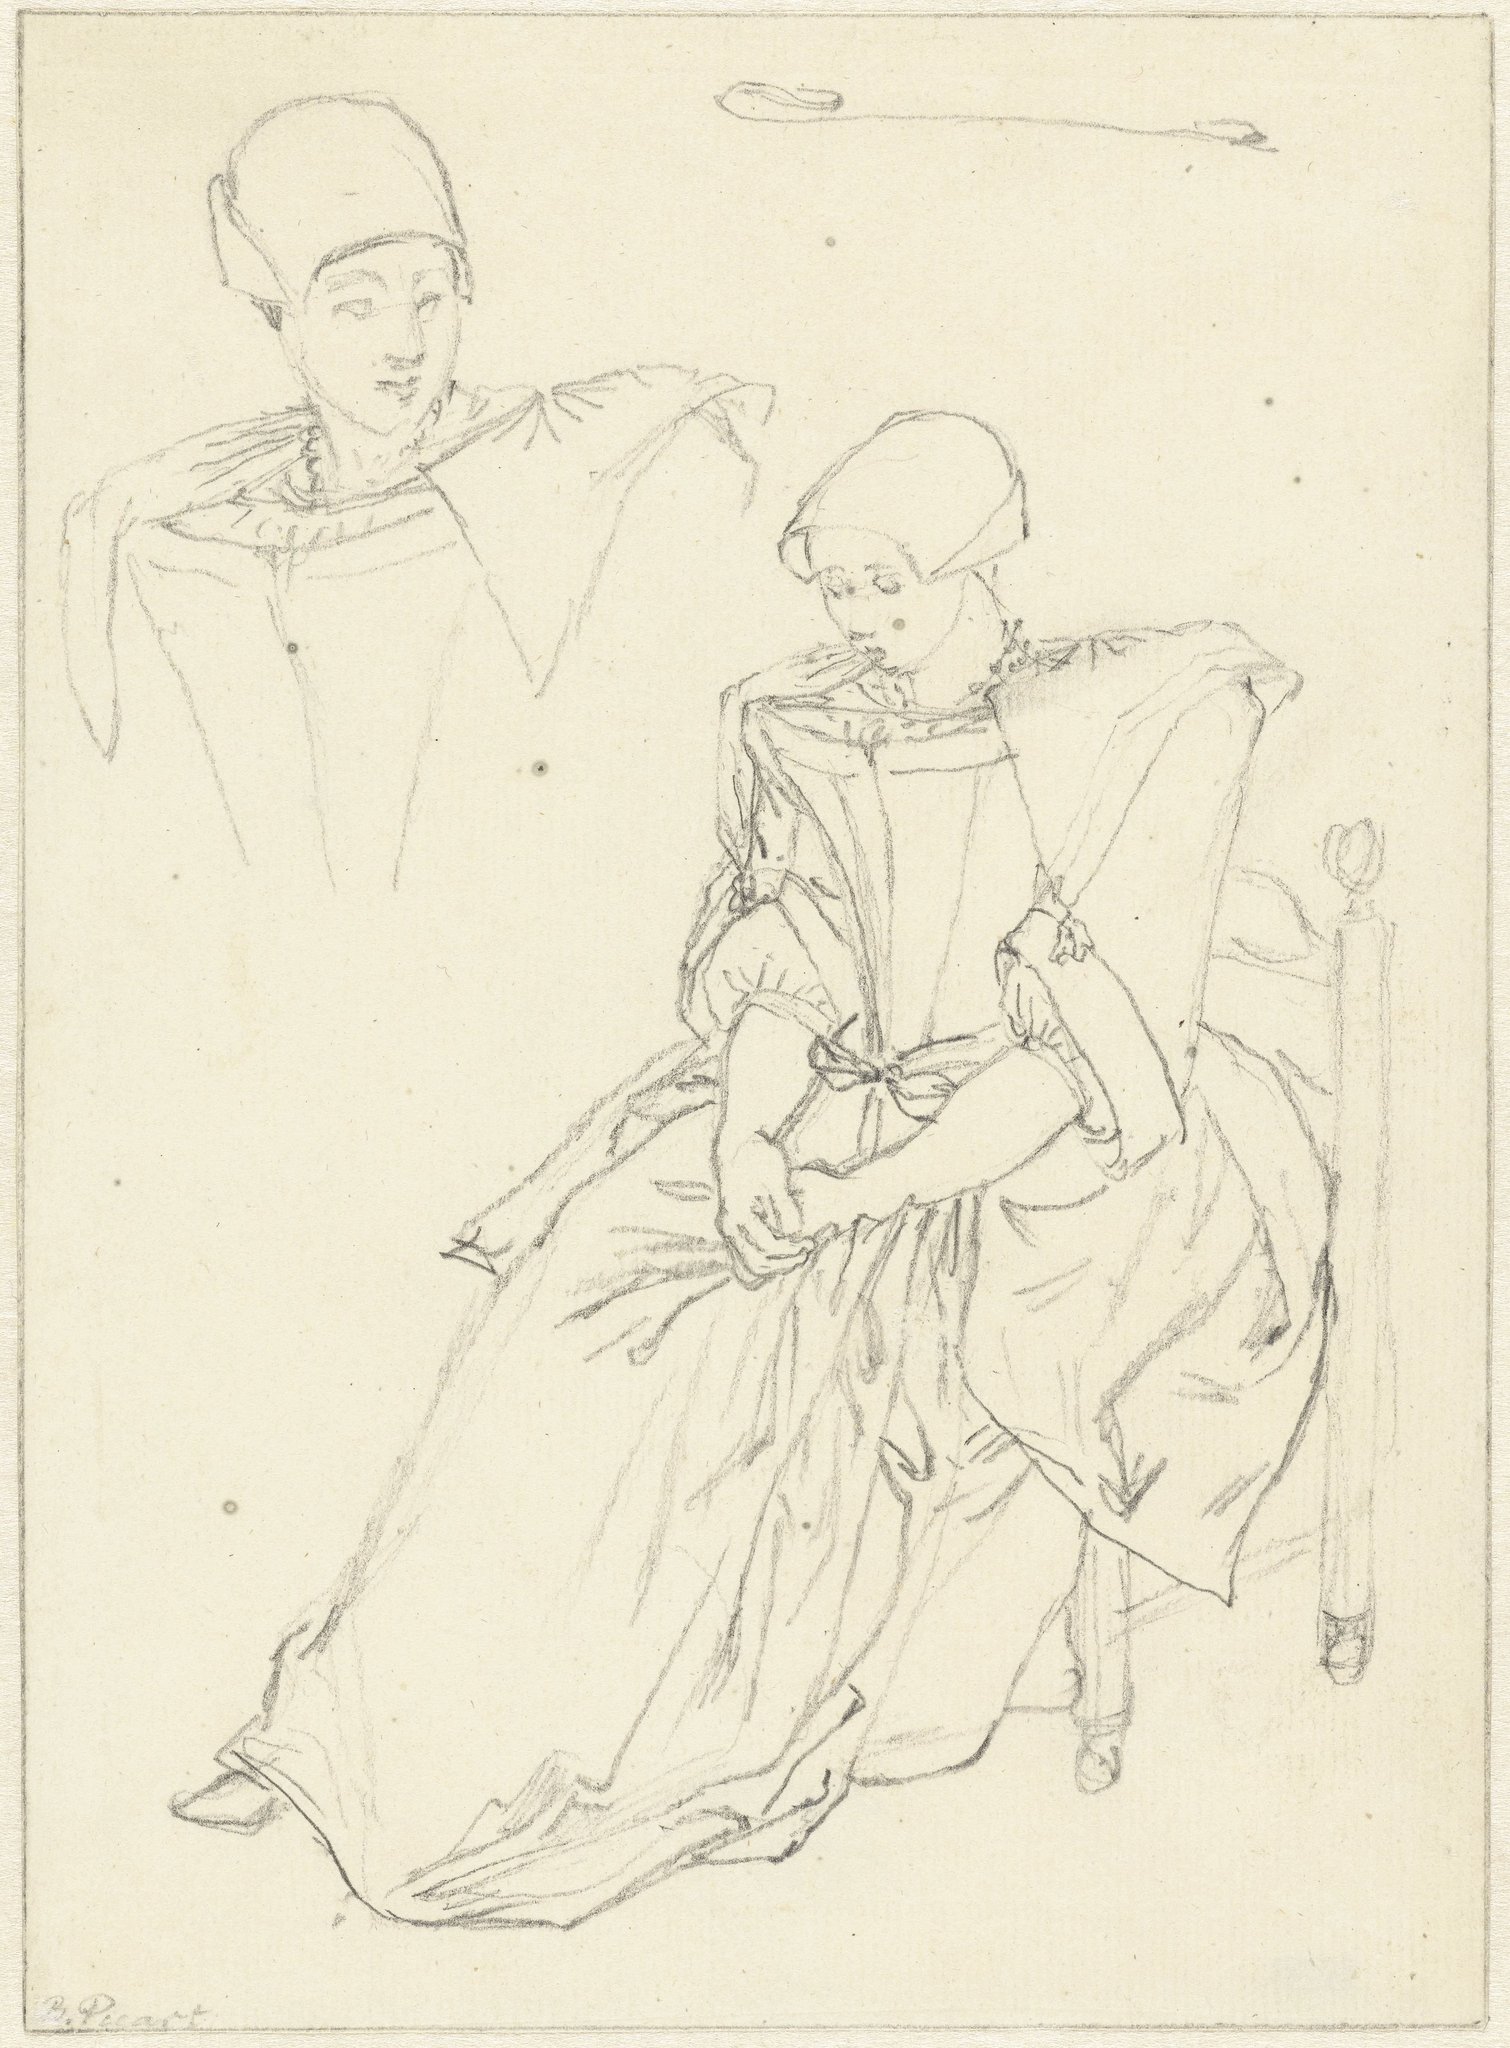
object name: drawing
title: Twee schetsen naar het kostuum van een vrouw uit Axel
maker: bernard picart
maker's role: draughtsman, print maker, publisher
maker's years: 1673-1733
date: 1683-1733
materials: paper, pencil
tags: folk costume, regional costume